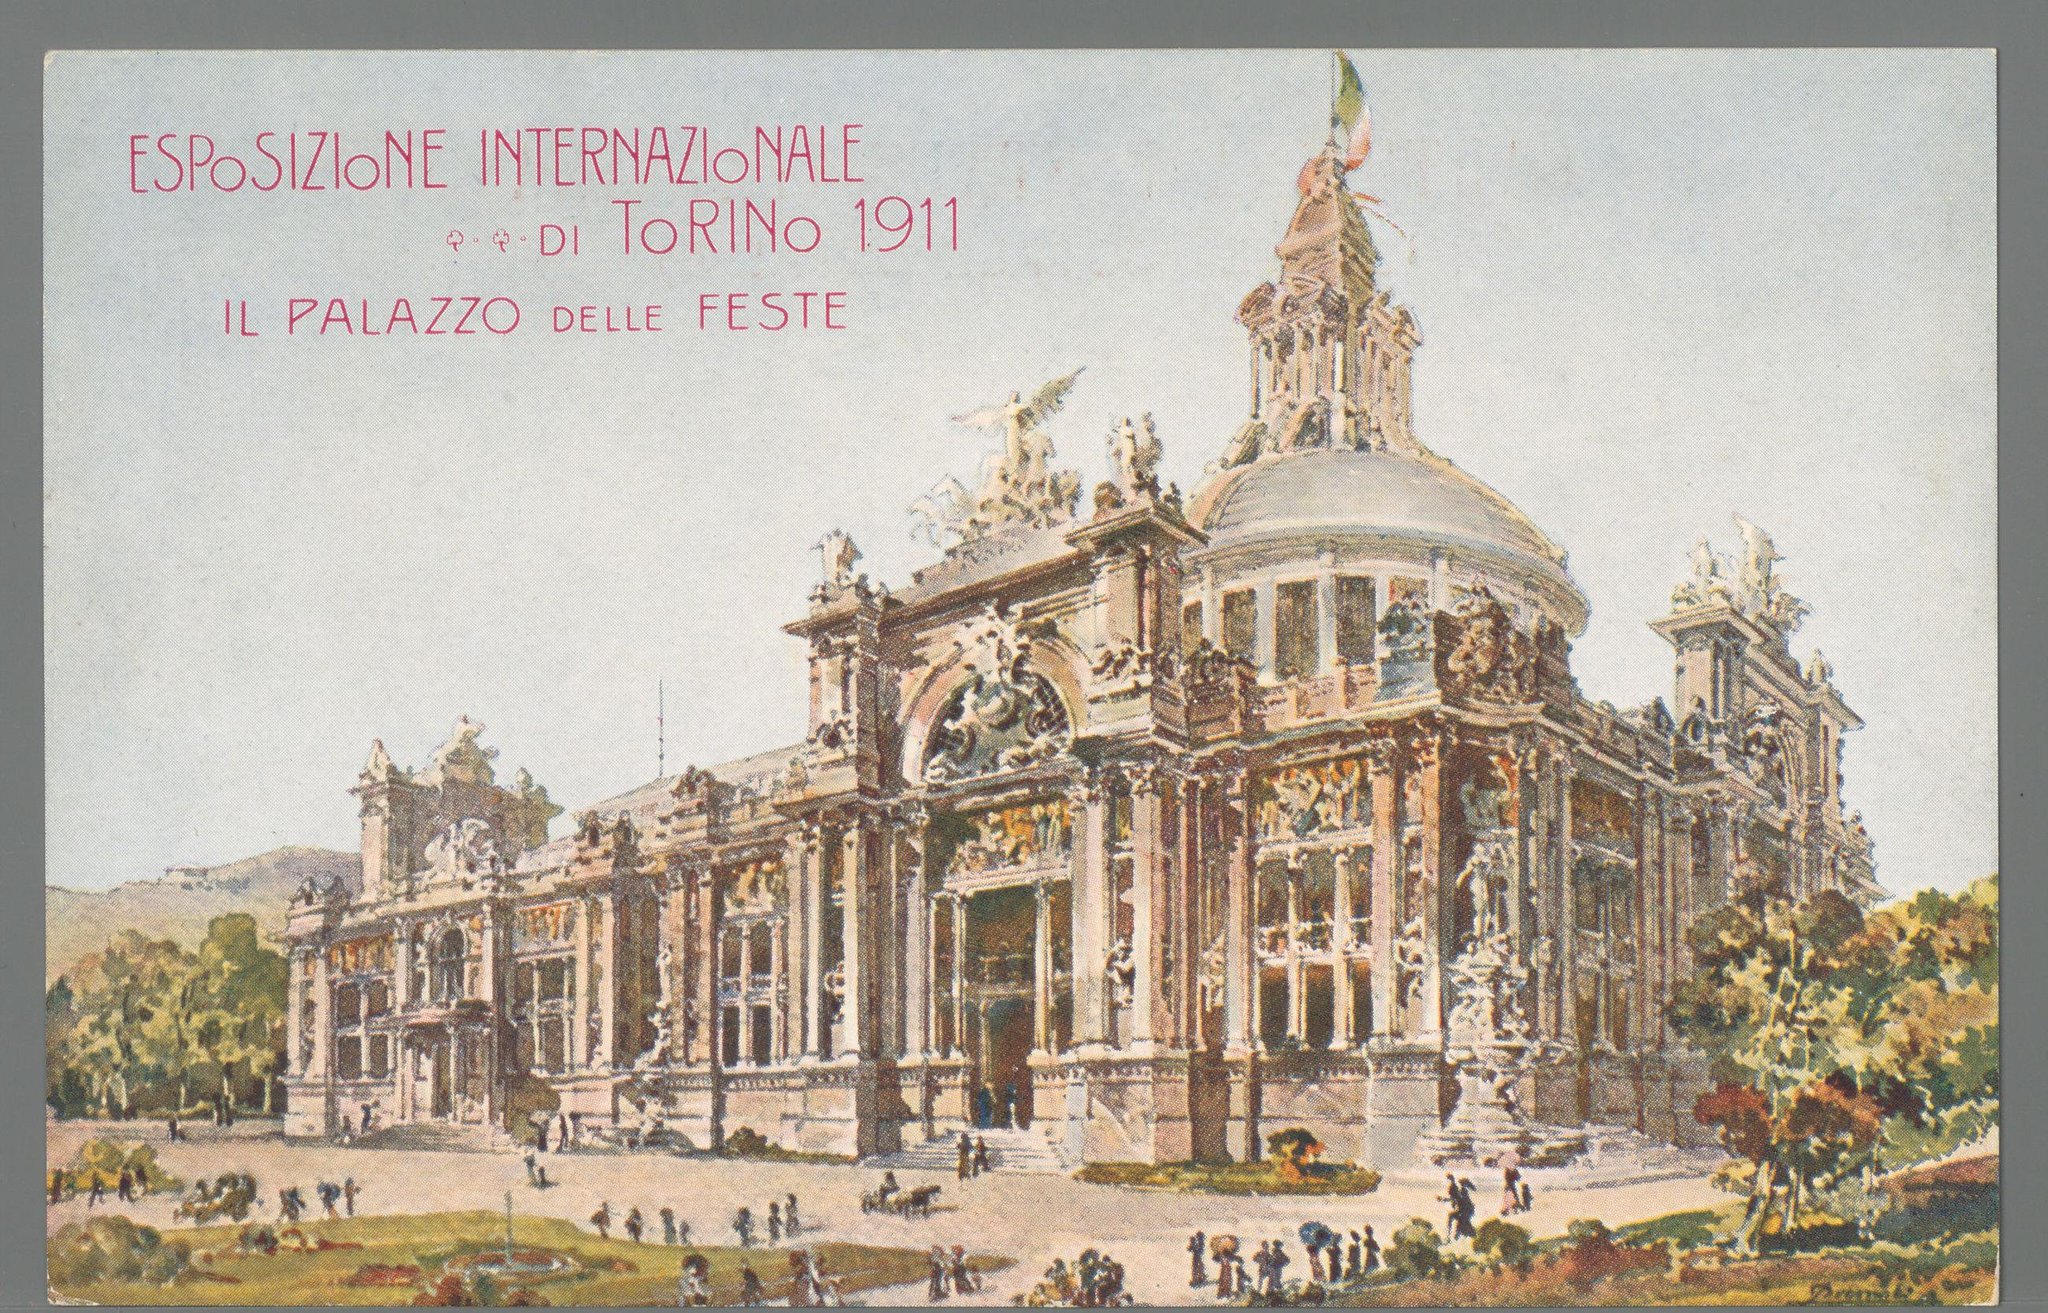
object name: photomechanical print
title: Il Palazzo delle Feste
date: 1910-1911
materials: cardboard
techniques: three-color autotype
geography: italy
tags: world fair, world exhibition, palace, turin international